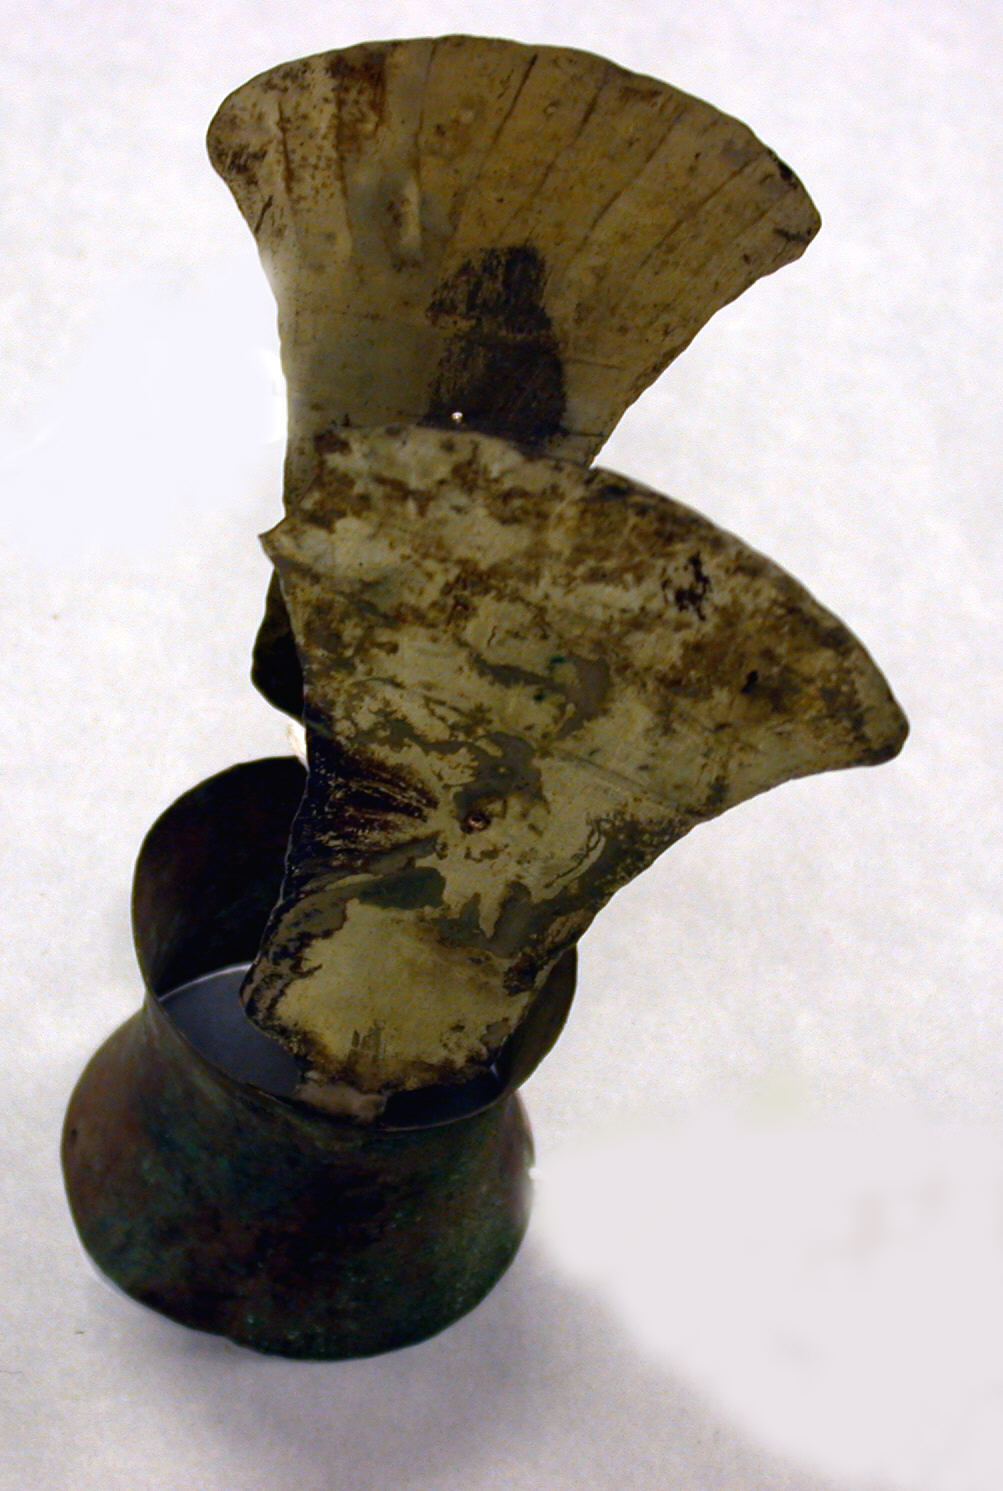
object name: crown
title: Hammered Silver Miniature Crown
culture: peruvian, north or central coast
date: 1001-1566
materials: gilt, silver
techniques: hammering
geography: peru